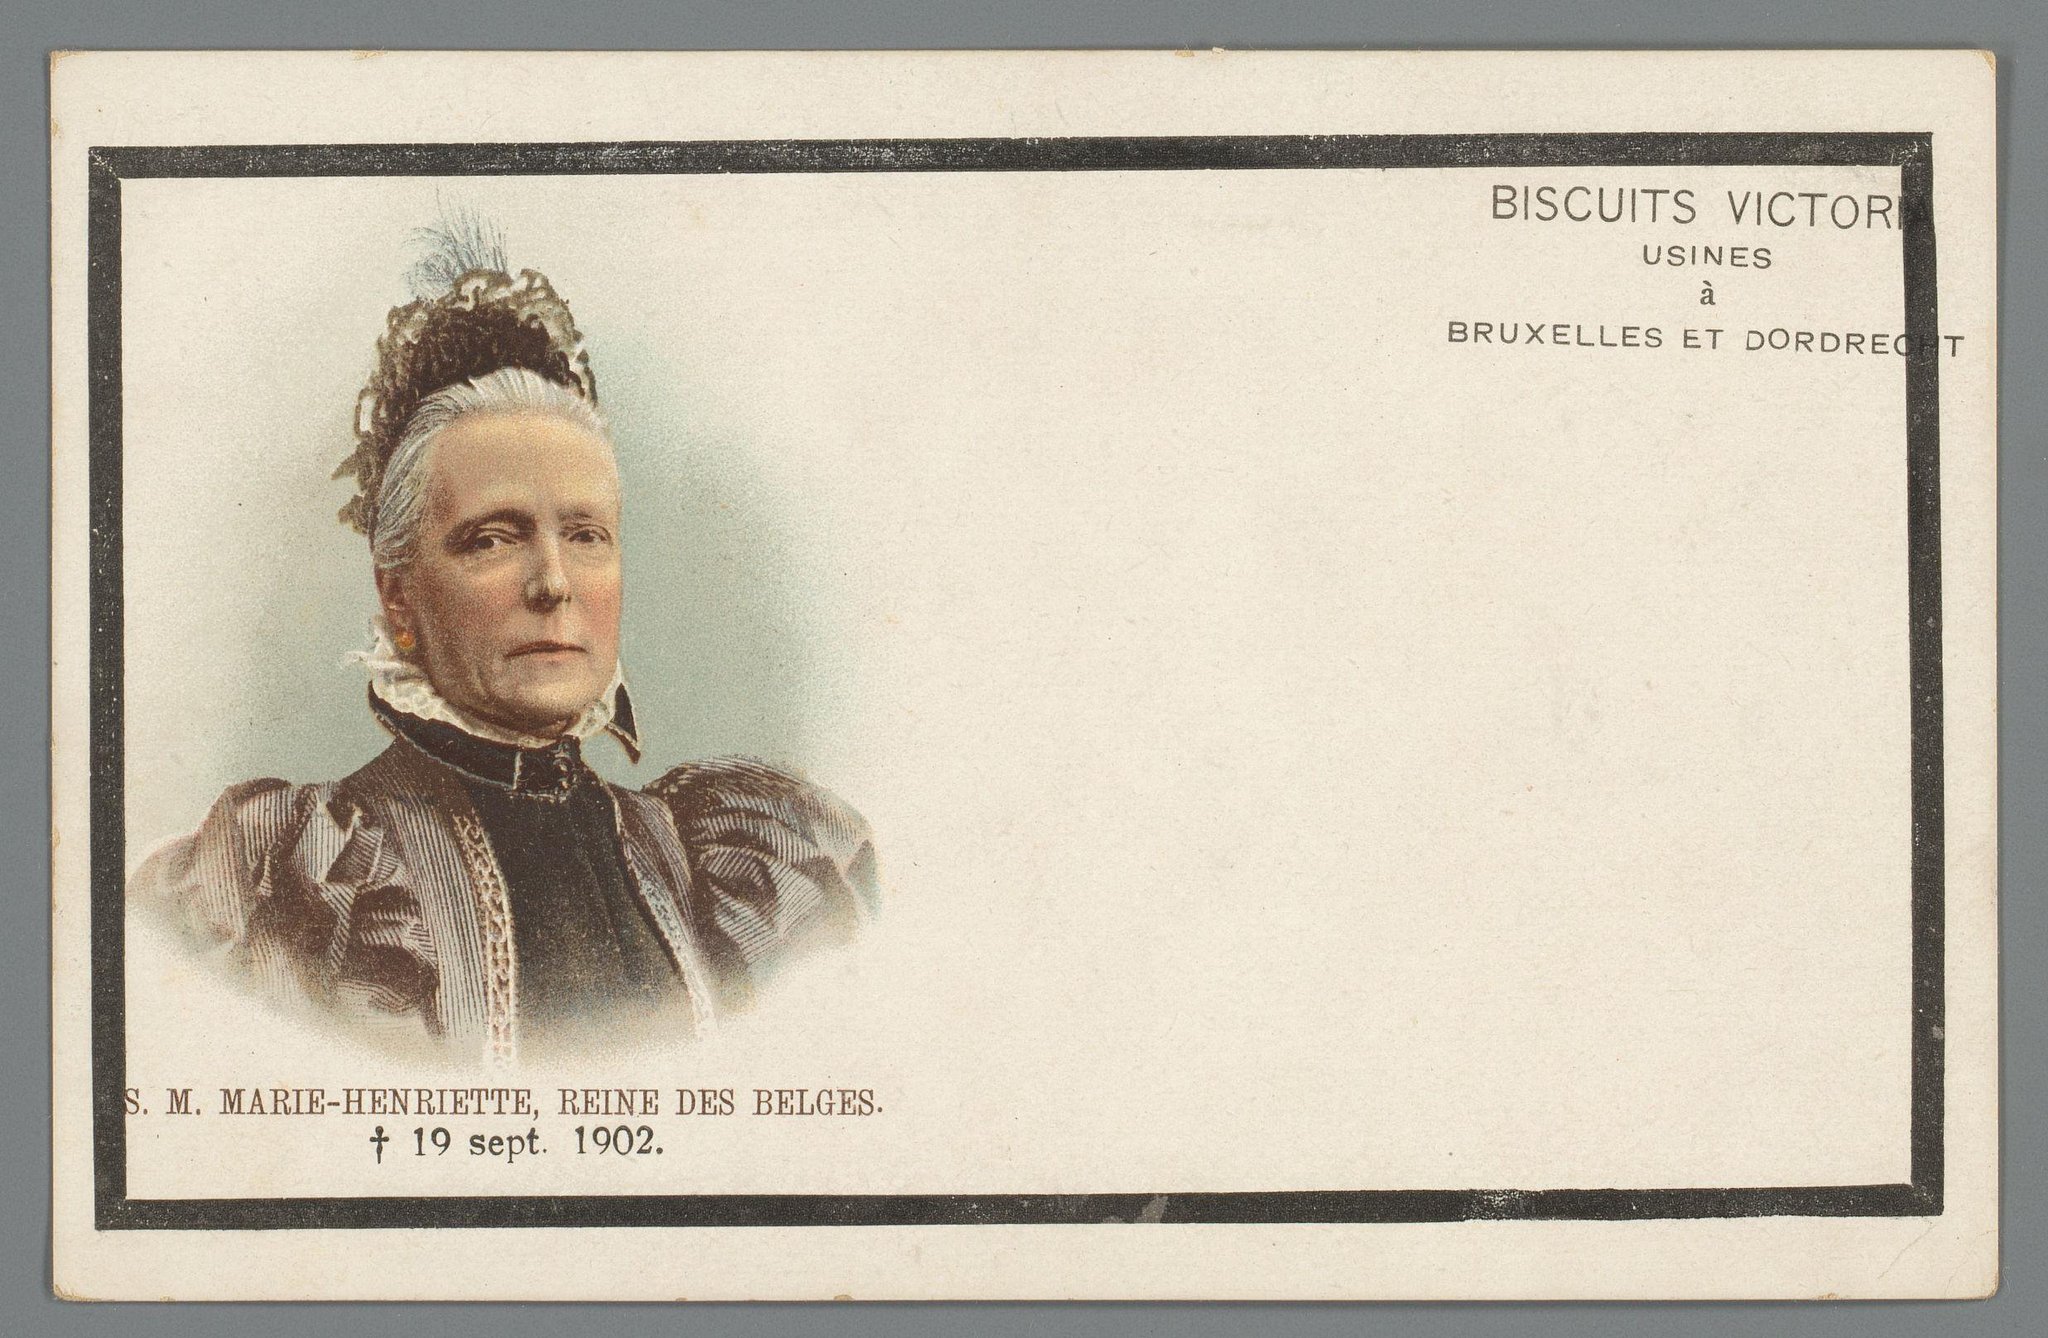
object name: photomechanical print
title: S.M. Marie-Henriette, Reine des Belges. † 19 sept. 1902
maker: Anonymous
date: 1902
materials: cardboard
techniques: lithograph, letterpress printing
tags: historical persons - bb - woman, queen, empress, etc. (wife of a ruler)